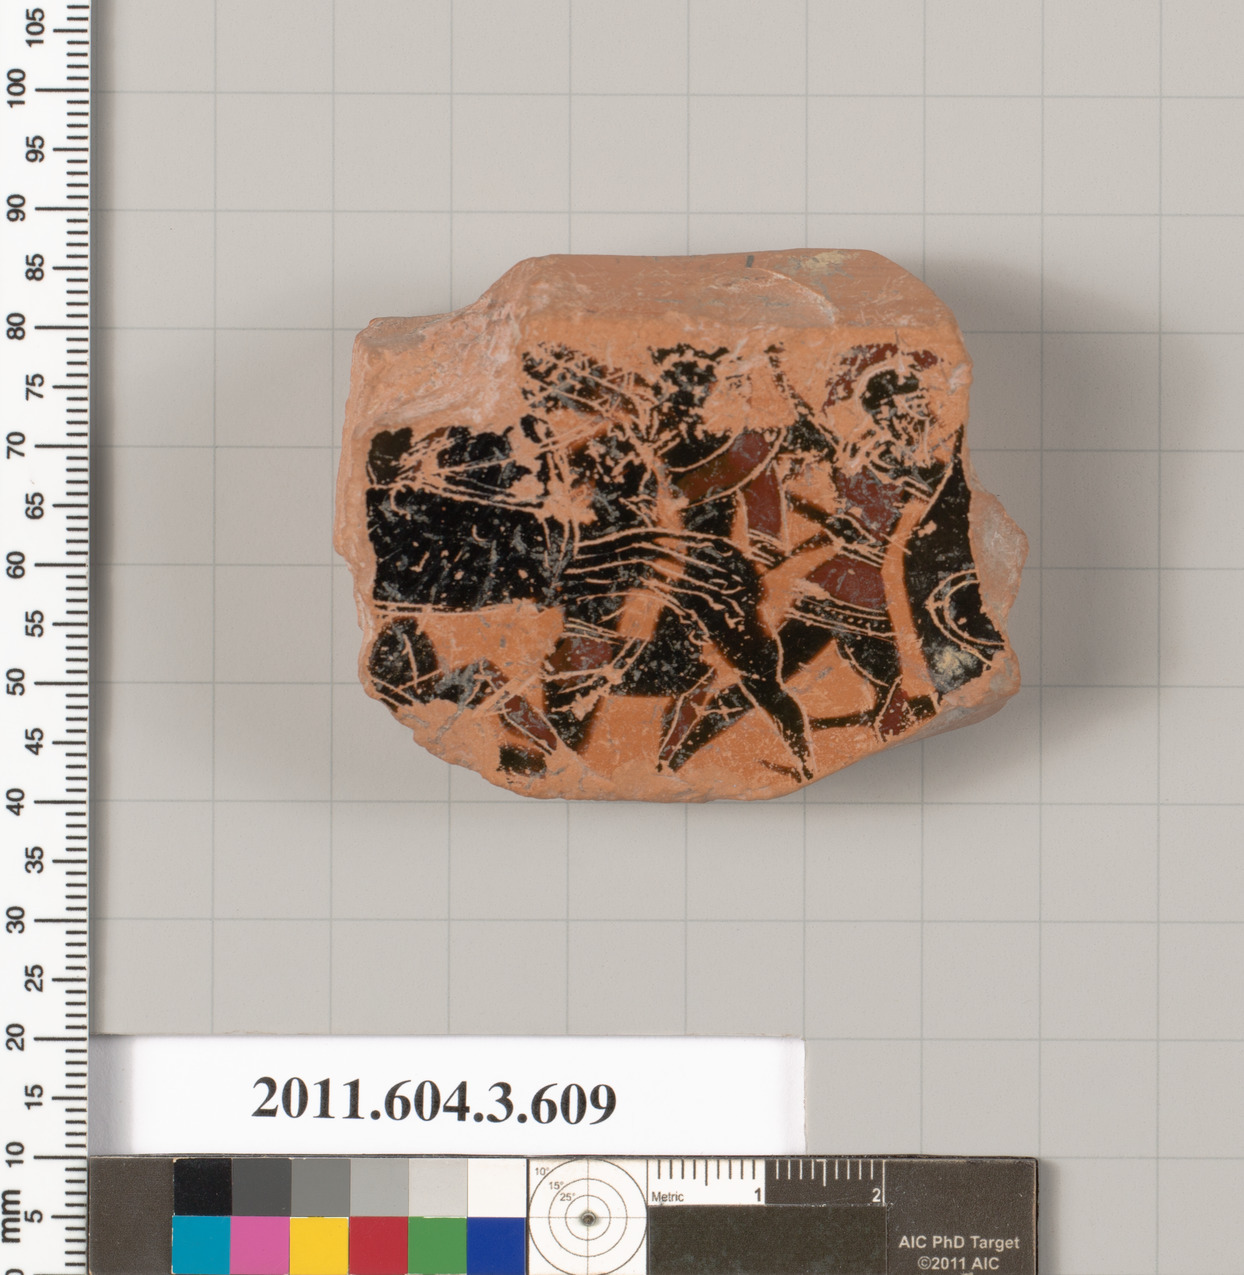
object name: column krater fragment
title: Terracotta fragment of a column-krater (bowl for mixing wine and water)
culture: greek, attic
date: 550-526 BCE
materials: terracotta